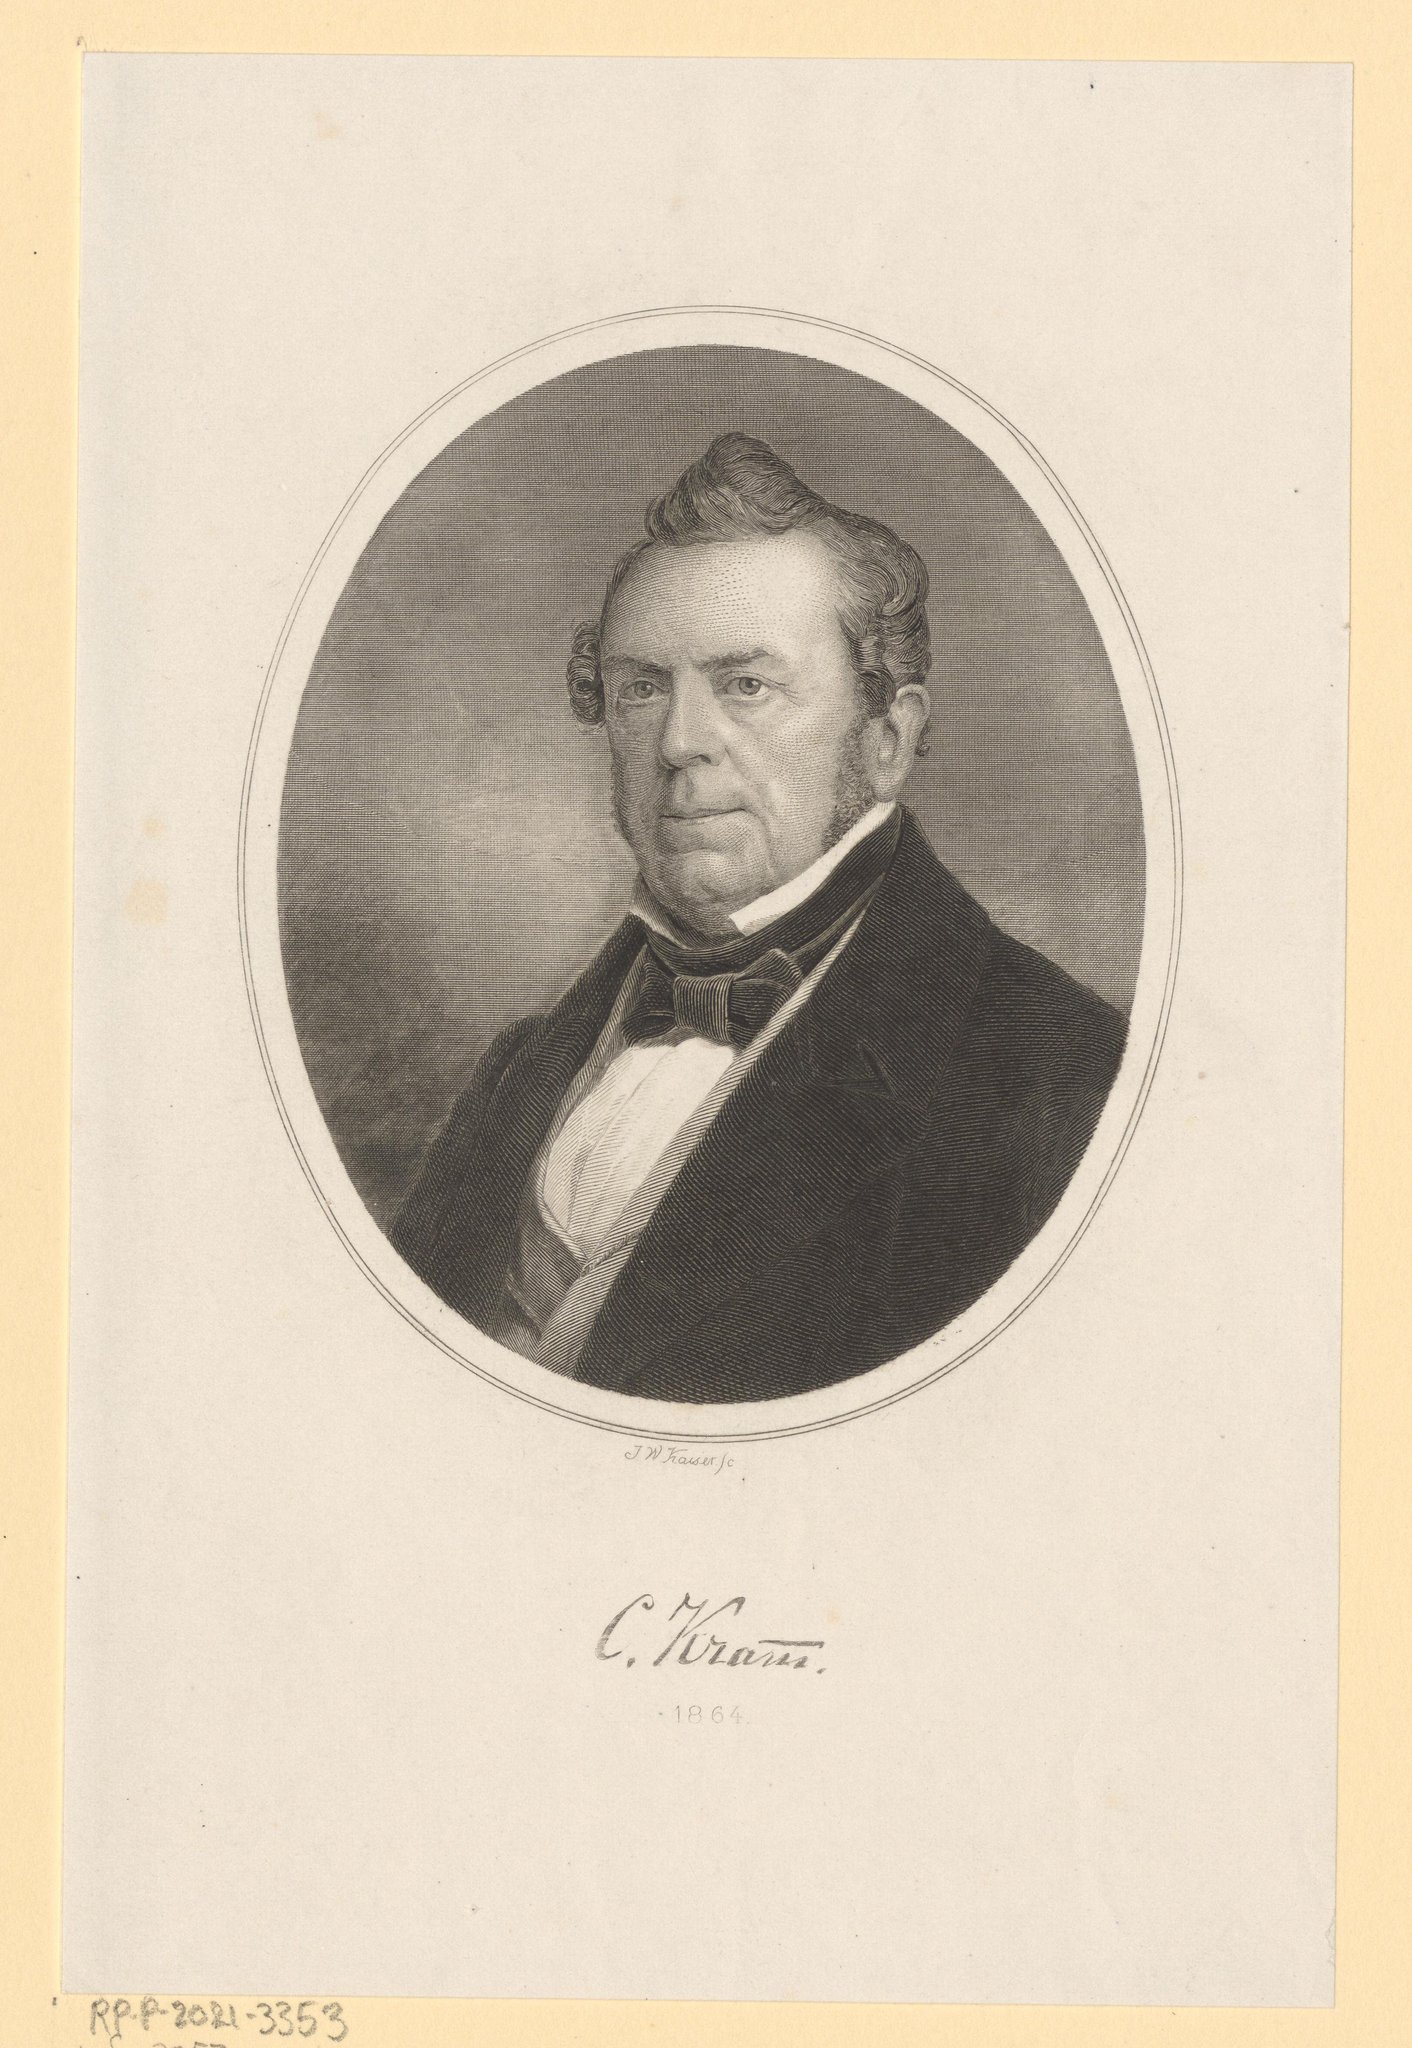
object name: print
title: Portret van Christiaan Kramm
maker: johann wilhelm kaiser (i)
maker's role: draughtsman, print maker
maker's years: 1813-1900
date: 1864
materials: paper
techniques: engraving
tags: utrecht, print maker, christiaan kramm, historical persons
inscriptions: date